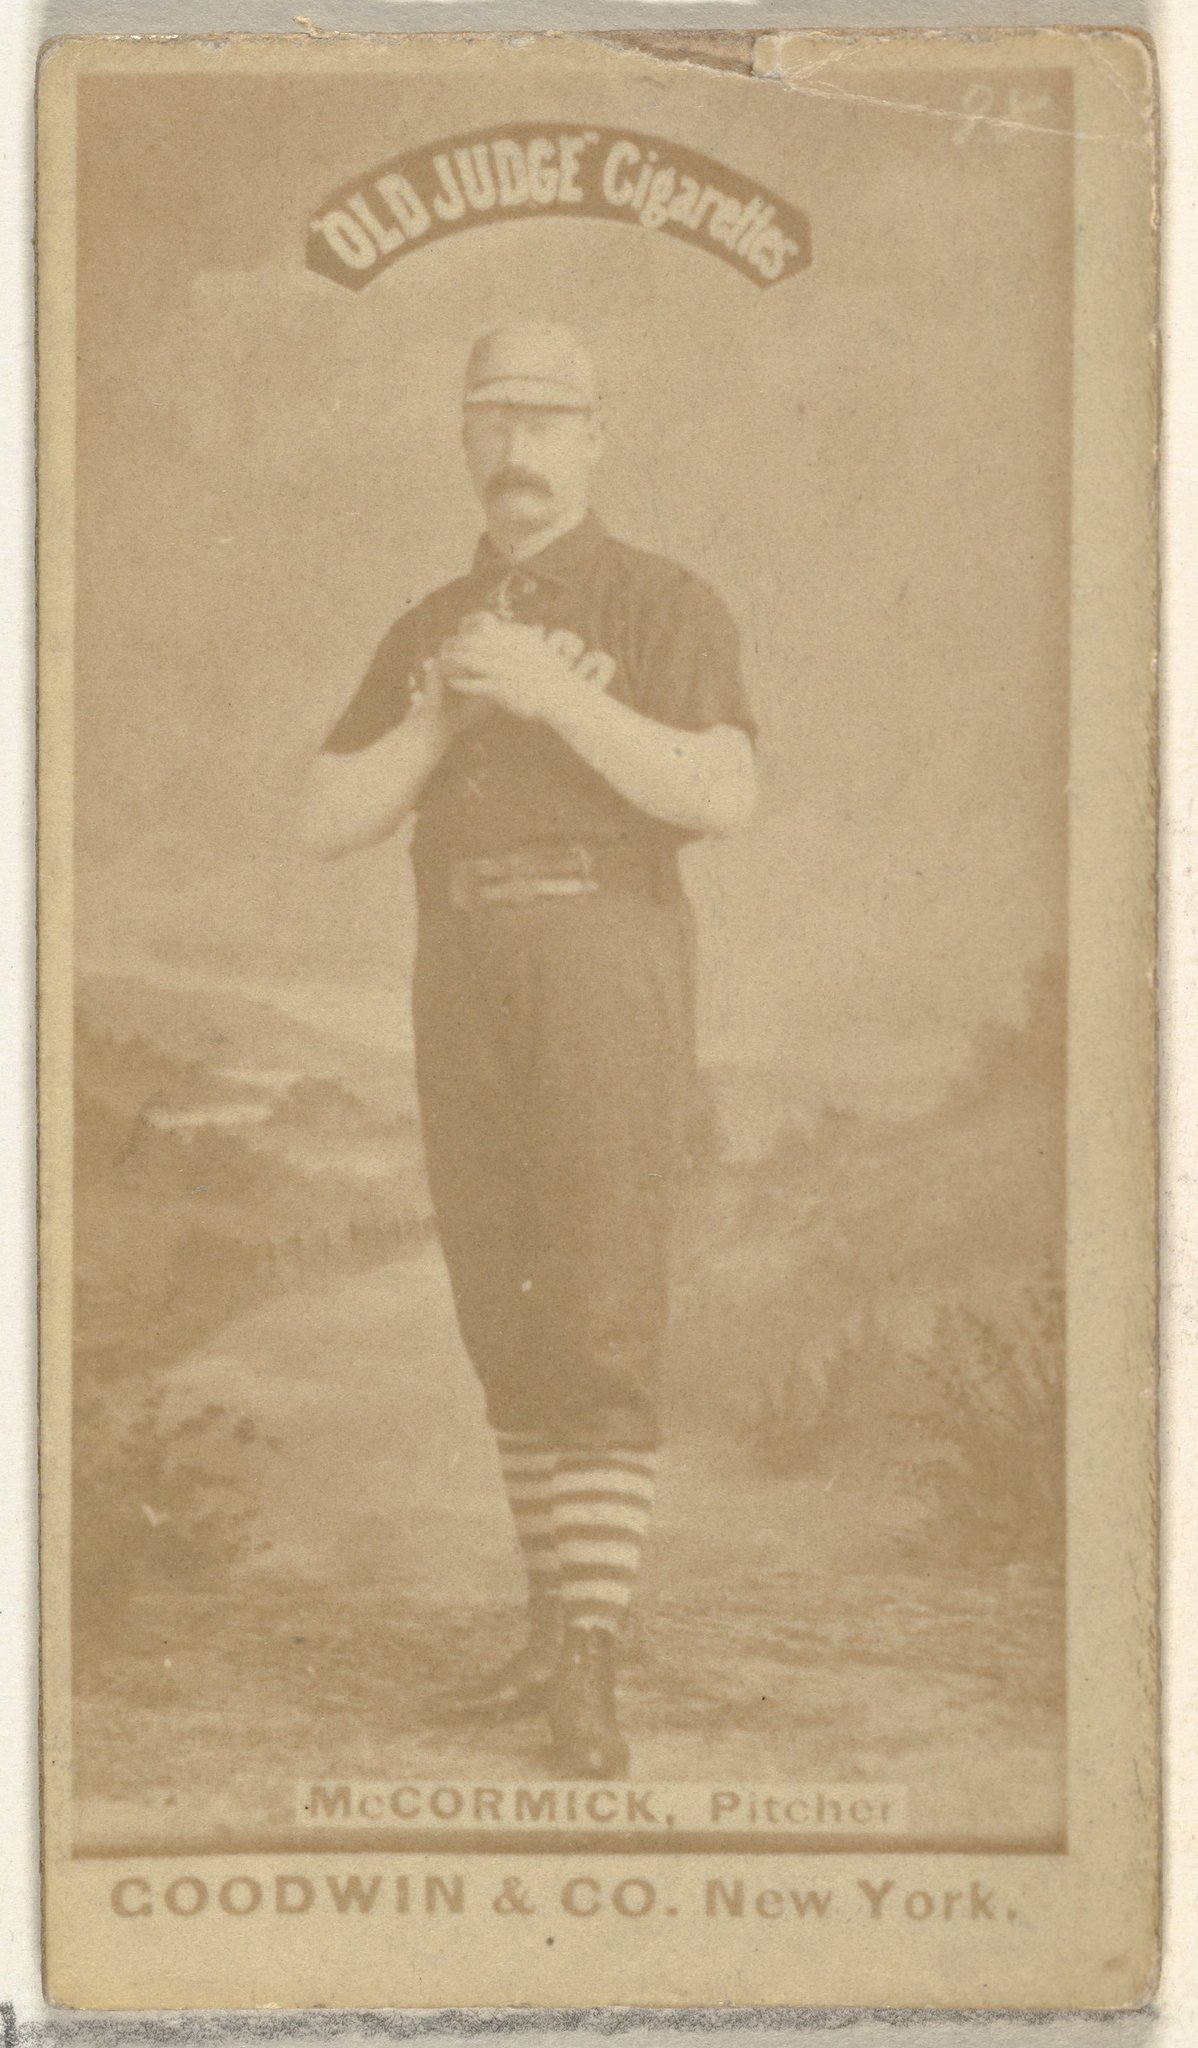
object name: baseball card, photograph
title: James "Jim" McCormick, Pitcher, Pittsburgh Alleghenys, from the Old Judge series (N172) for Old Judge Cigarettes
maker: goodwin & company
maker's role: publisher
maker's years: 1850-1950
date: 1887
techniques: albumen silver print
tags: men,portraits,baseball,athletes